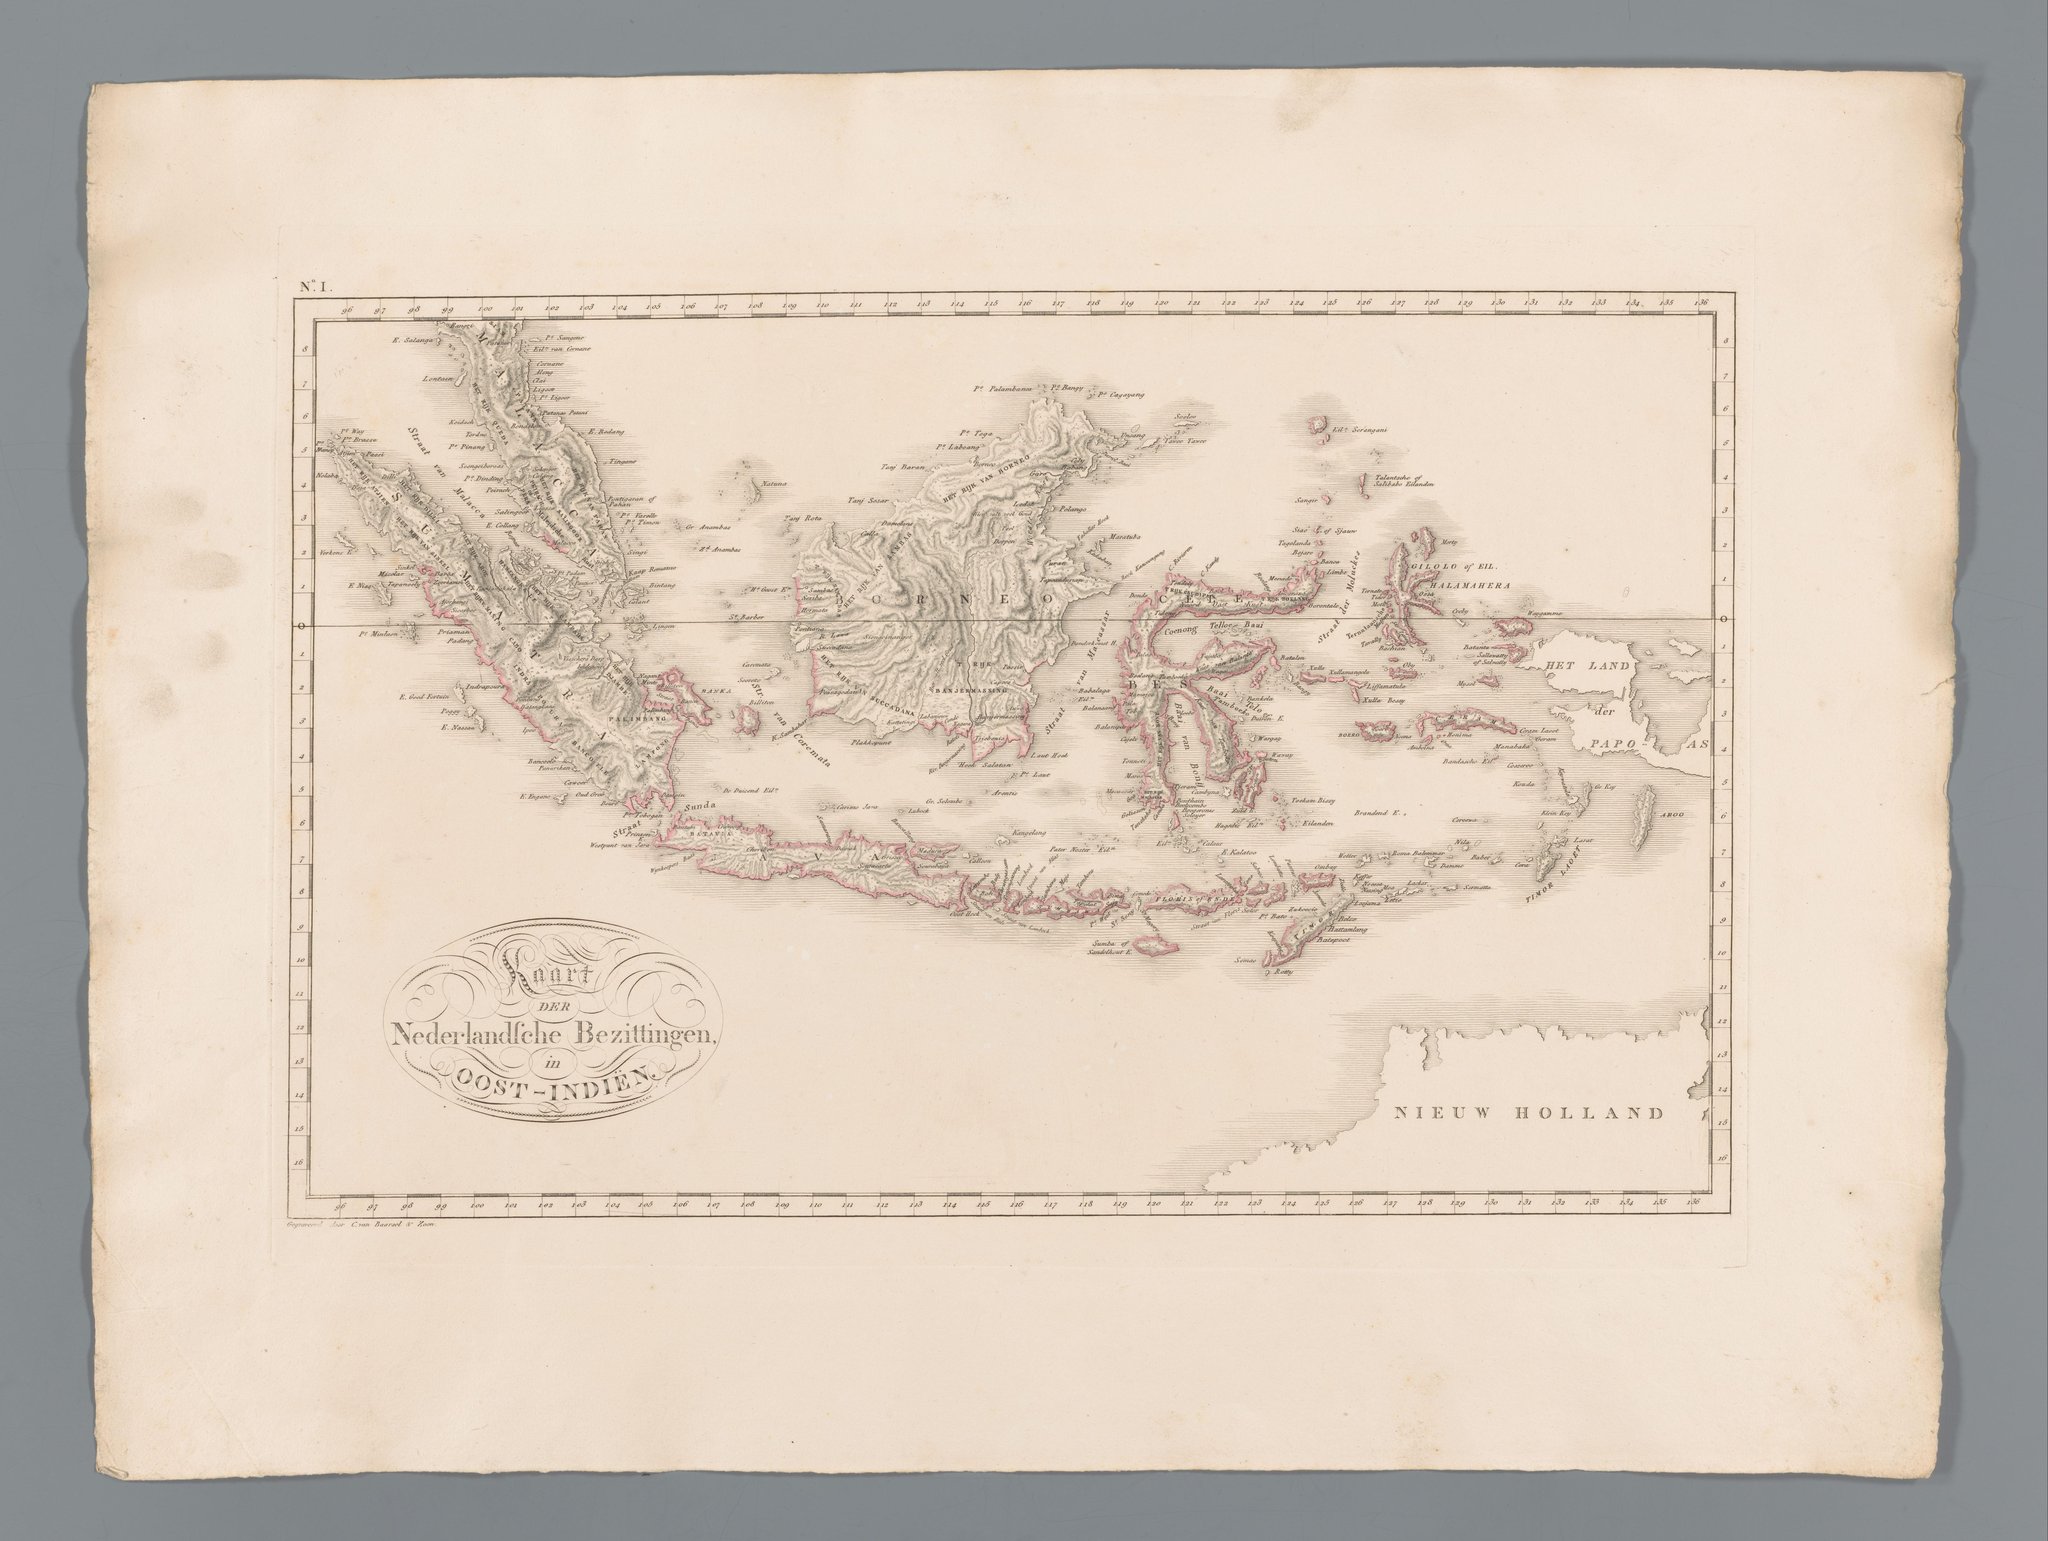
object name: map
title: Kaart der Nederlandsche bezittingen in Oost-Indiën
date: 1818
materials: paper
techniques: engraving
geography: the hague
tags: maps of separate countries or regions, indonesia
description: Kaart uit: Bosch, Js. van den. Atlas der overzeesche bezittingen van Zijne Majesteit den Koning der Nederlanden, aan hoogst denzelven opgedragen. Den Haag en Amsterdam: Gebroeders van Cleef, 1818.